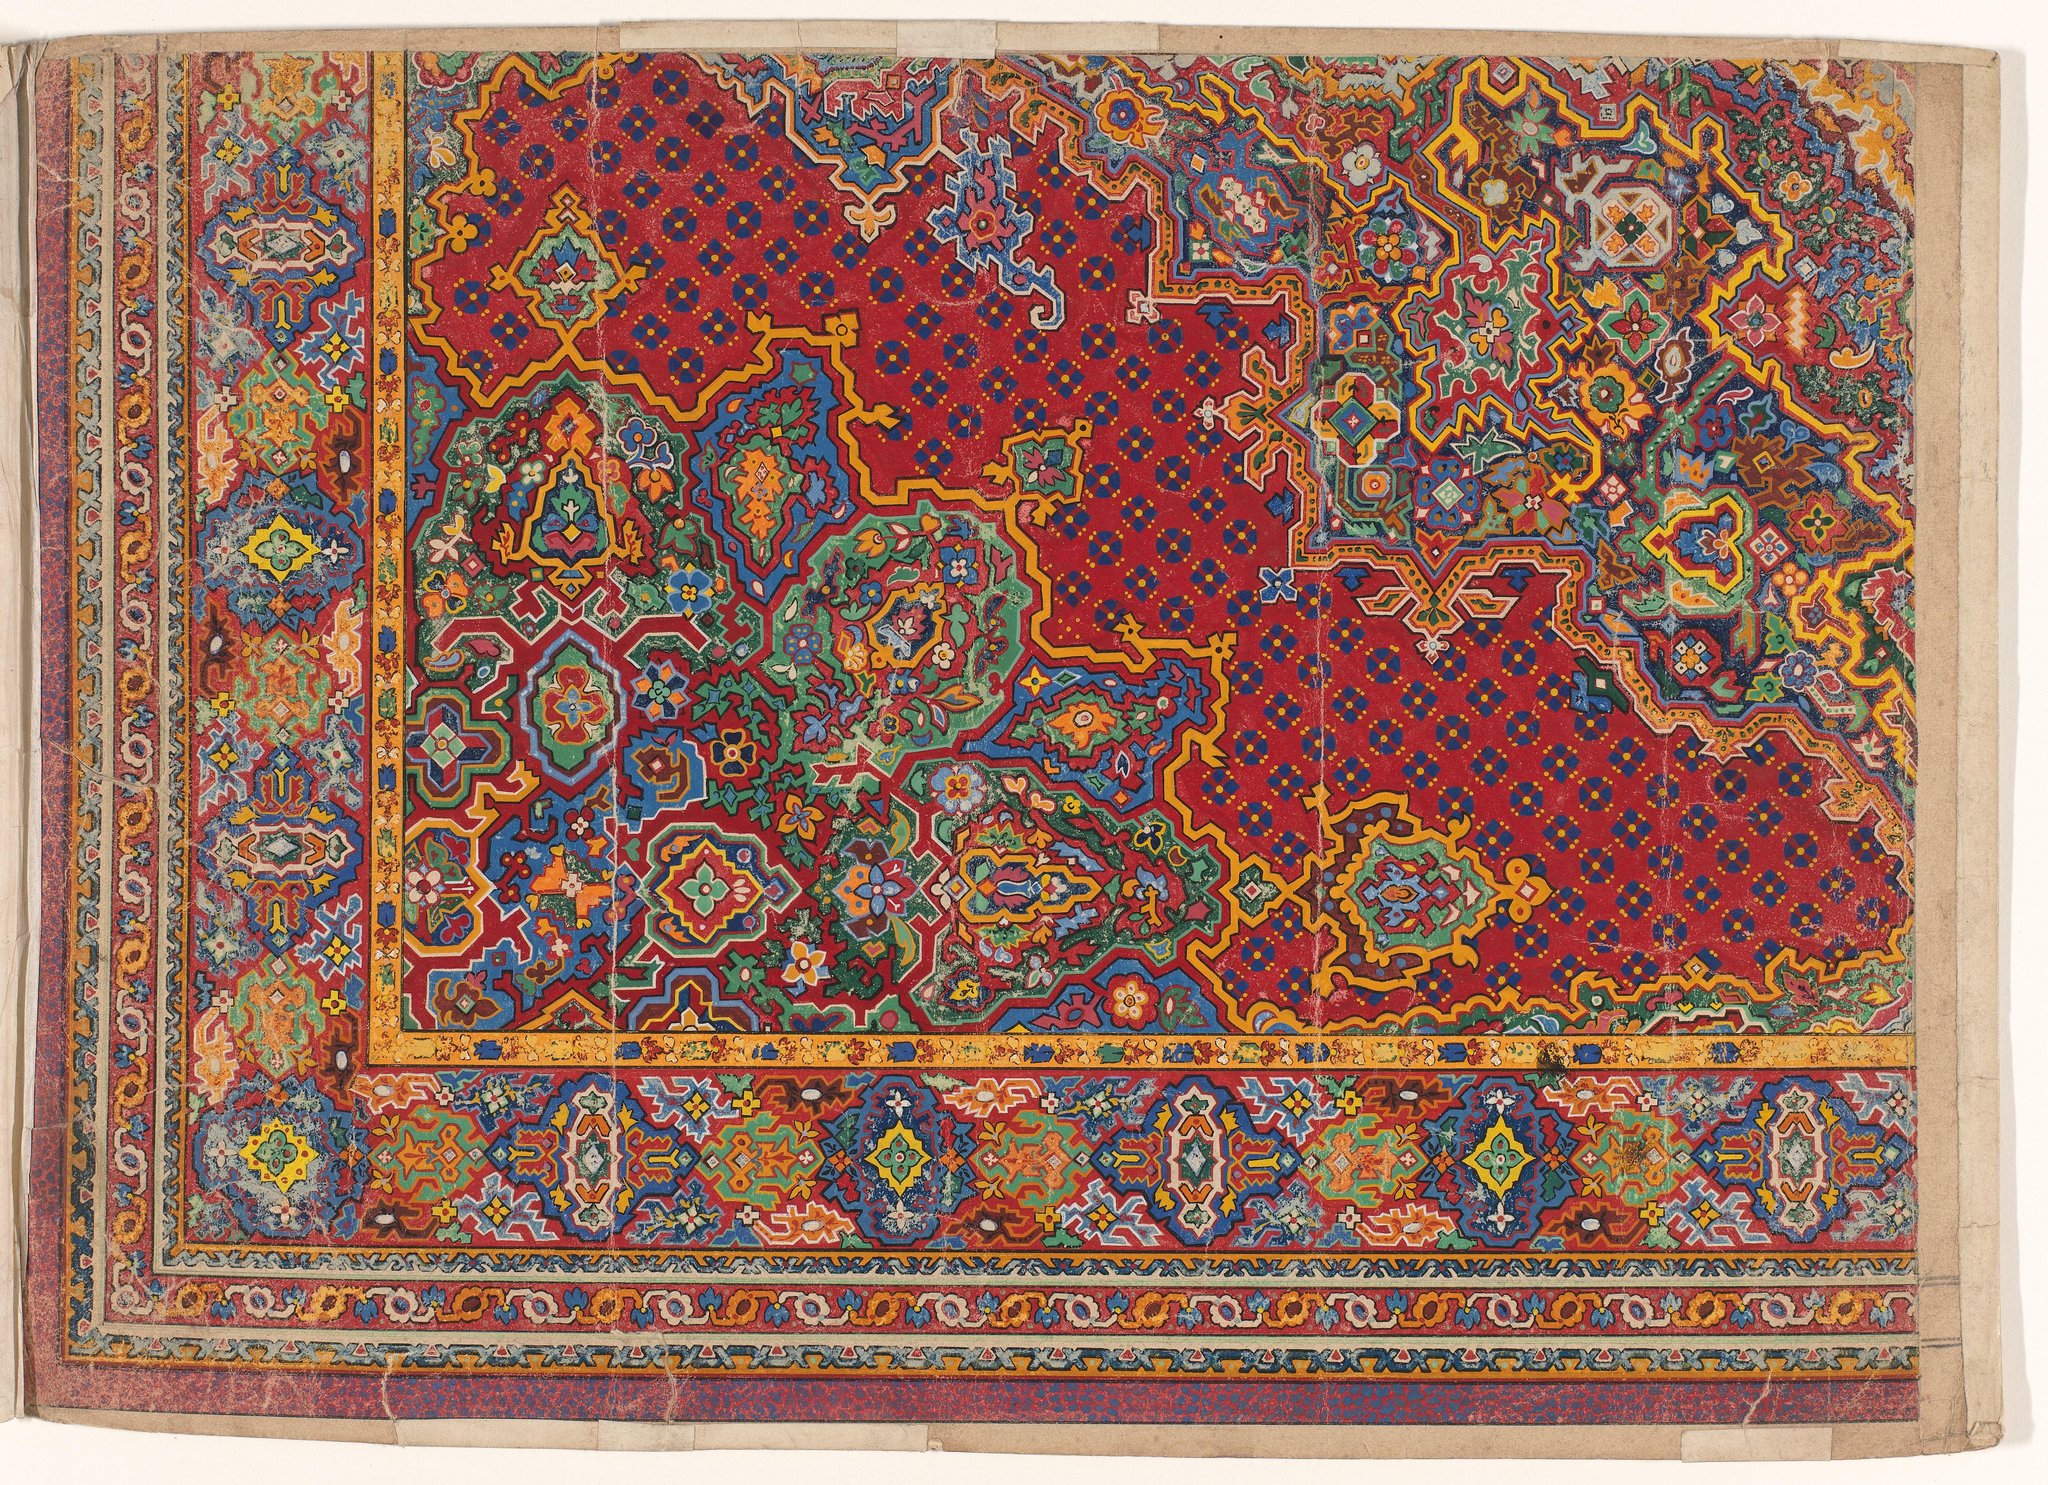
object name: drawing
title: Ontwerp voor een tapijt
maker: Anonymous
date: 1854-1864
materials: gouache, paper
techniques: brush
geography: amsterdam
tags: ornaments ~ art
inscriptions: inscription: ‘voor de fond/ zi[...] al[...]e’, inscription: ‘gekozen XI 26 Jan[...] 1854/ [...]’, retailer's mark: ‘JHS.’, inscription: ‘X s.’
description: Een tapijt vervaardigd naar voorbeeld van deze modeltekening maar met afwijkende sierrand is gebruikt bij de inrichting van de eetkamer van Huis van Brienen aan de Herengracht in Amsterdam. De presentatietekeningen BK-1971-77-1 t/m 86 zijn kopieën van de originele ontwerptekeningen. Ze werden gemaakt voor vertegenwoordigers van bijvoorbeeld magazijnen, die ze aan hun klanten konden tonen. De meeste tekeningen tonen een kwart van het dessin inclusief rand, middenpartij (de zogenaamde grond of fond) en centraal medaillon. Door het gebruik van spiegels kan de illusie van het gehele tapijt worden opgeroepen. Een deel van de tekeningen heeft een alfabetische opeenvolgende letter als kenmerk, de andere groep een cijfer.Waarschijnlijk is de reeks dessins met een letter eerder samengesteld dan de genummerde tekeningen.